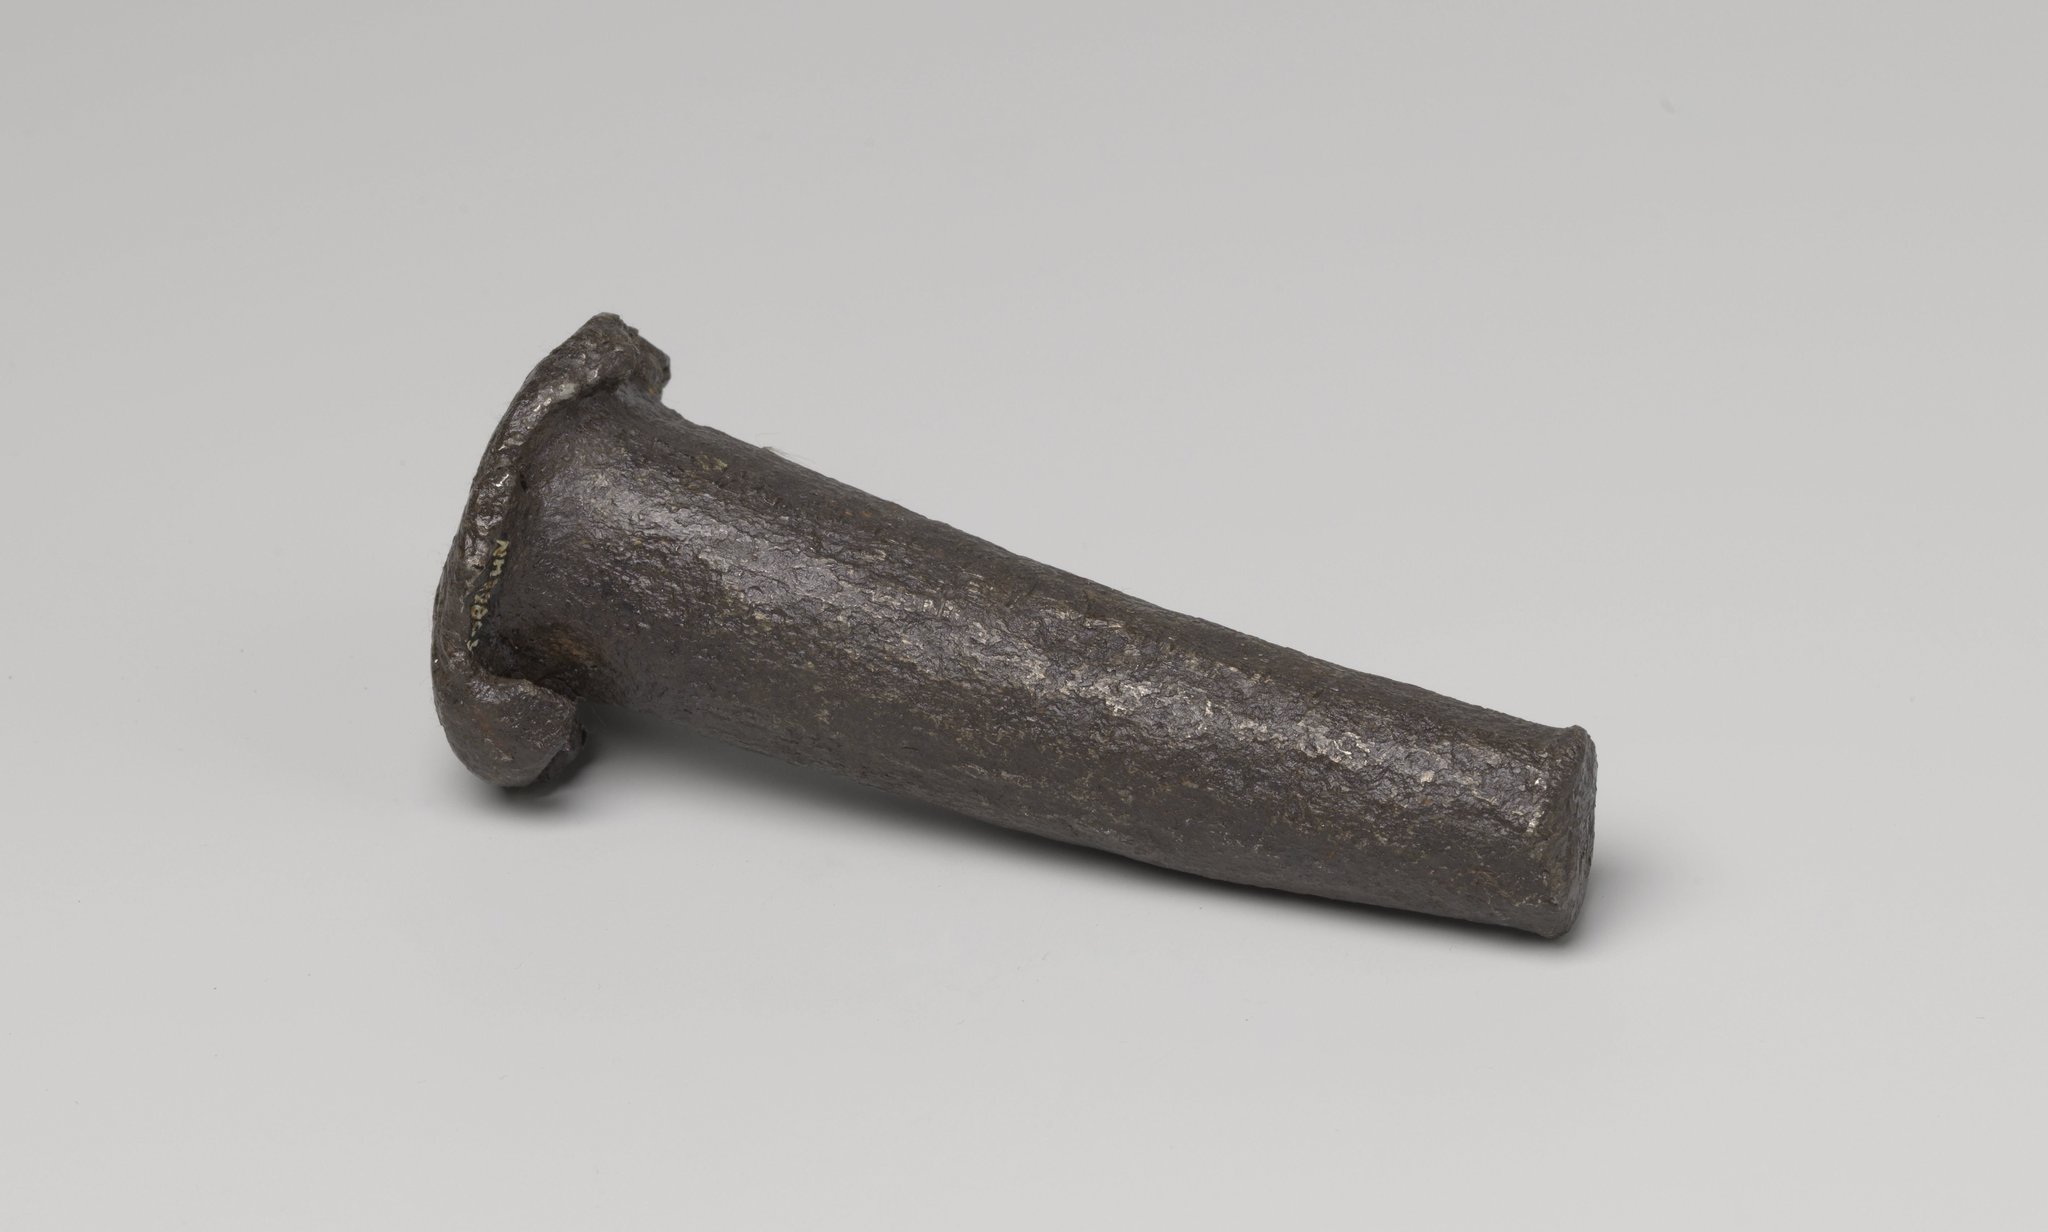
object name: nail set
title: Boutdrevel met platgeslagen kop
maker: Anonymous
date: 1590-1596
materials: iron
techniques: forging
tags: willem barendsz., amsterdam, jacob van heemskerck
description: Marling spike